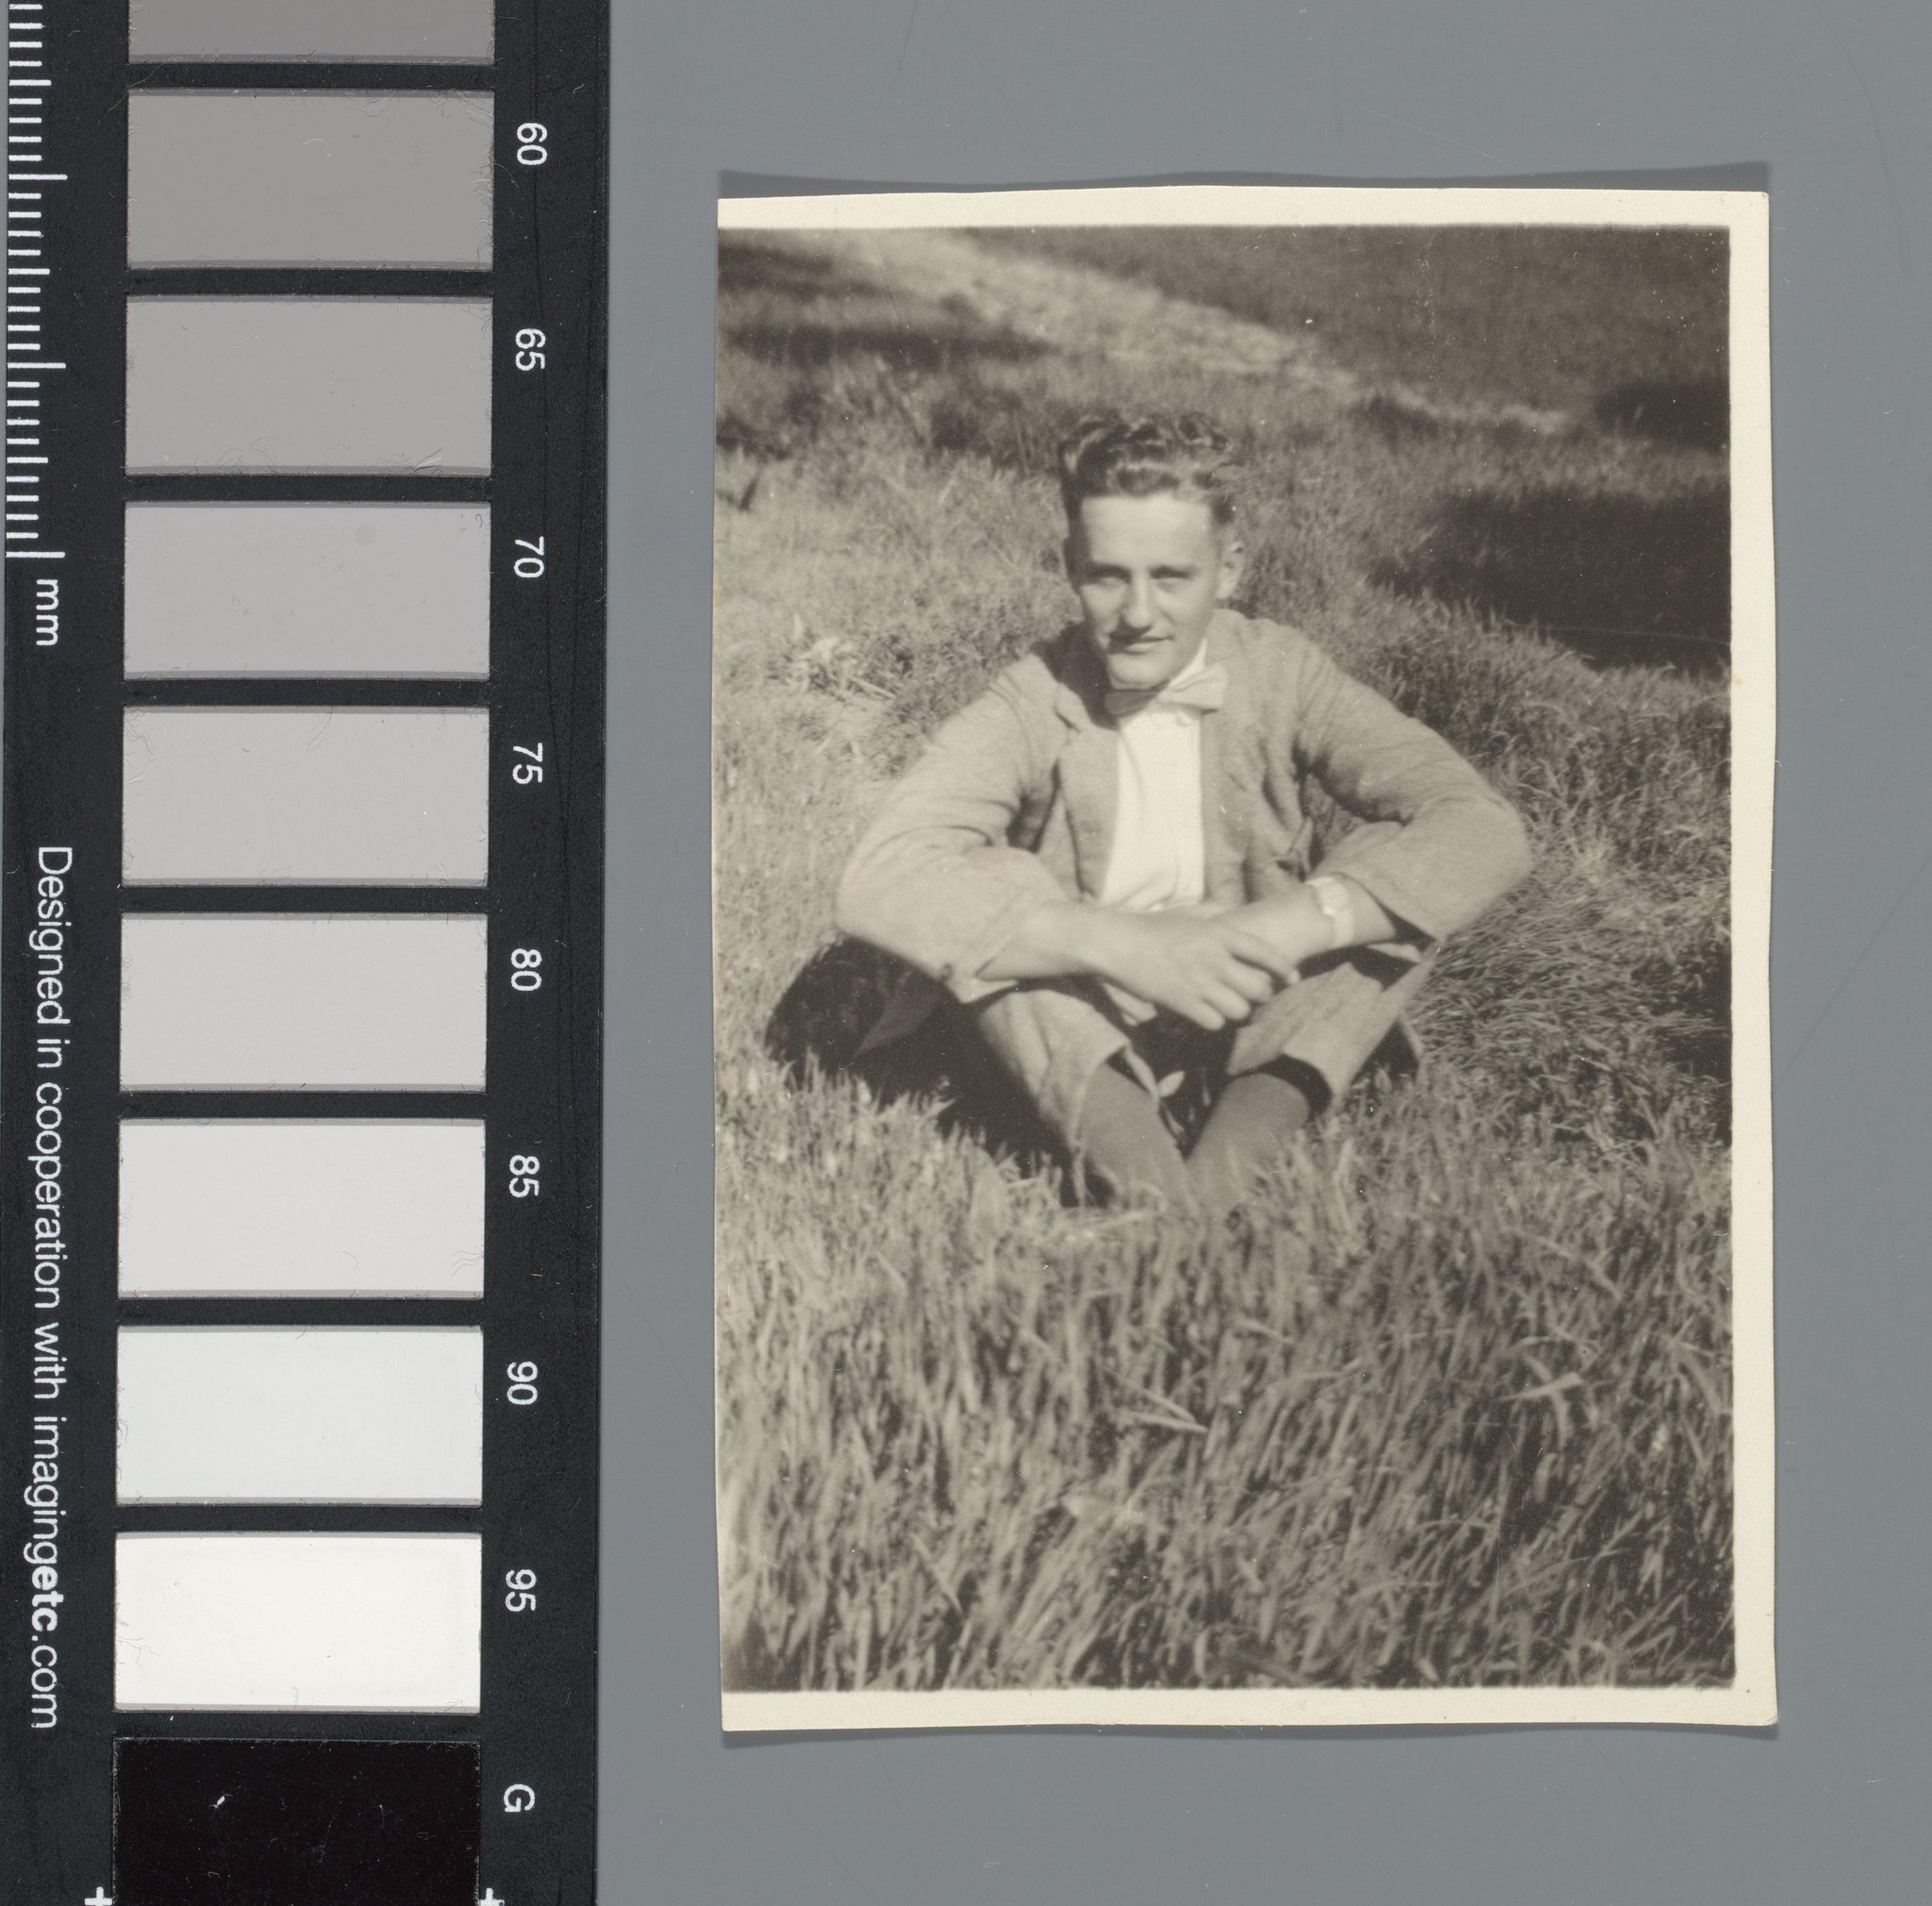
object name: photograph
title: Portret van Willem Jonker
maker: cornelia hendrika jonker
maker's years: 1874-1924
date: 1922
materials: photographic support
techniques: gelatin silver print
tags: historical persons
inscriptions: annotation: ‘Mr. William Jonker/ Voorjaar 1922’